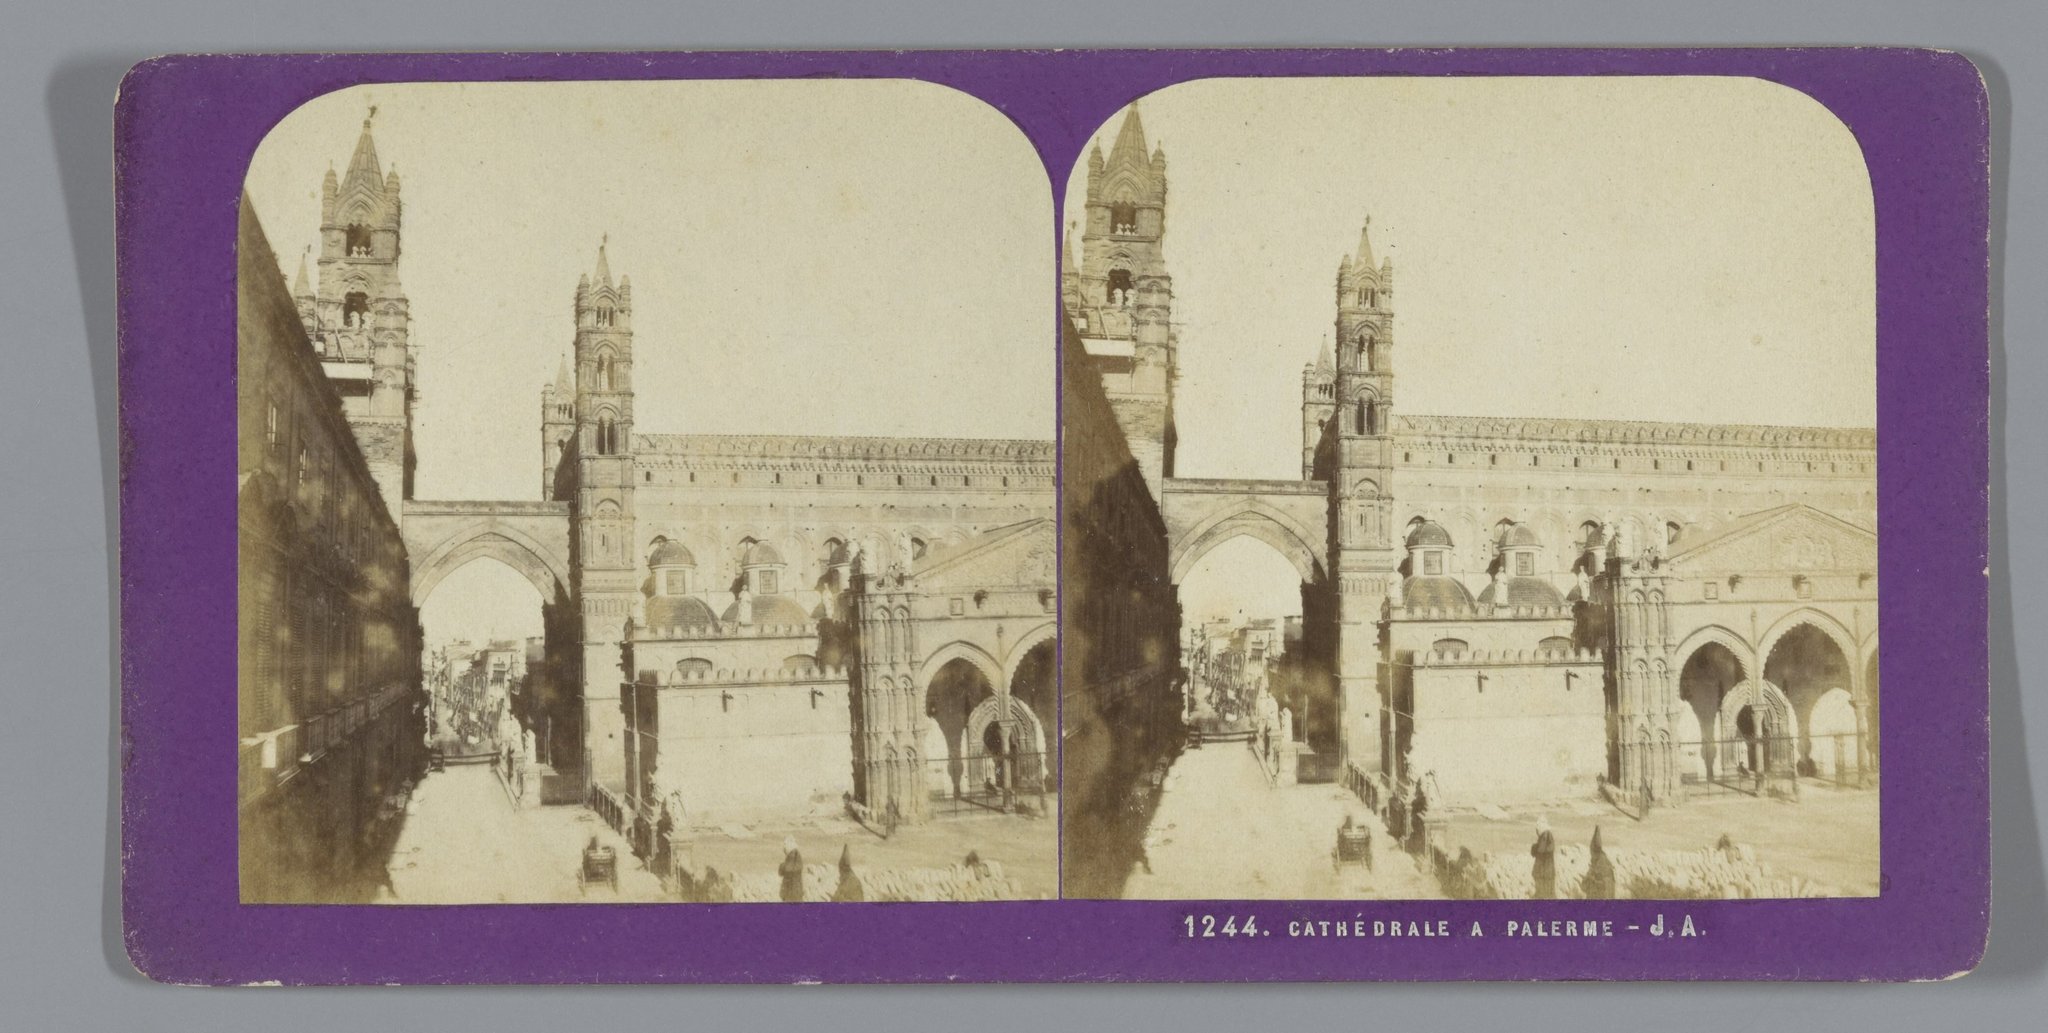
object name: stereograph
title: Cathédrale a Palerme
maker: jean andrieu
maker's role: fotograaf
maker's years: 1816-1872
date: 1862-1876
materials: cardboard, paper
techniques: albumen print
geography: palermo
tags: church (exterior)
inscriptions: number: ‘1244’